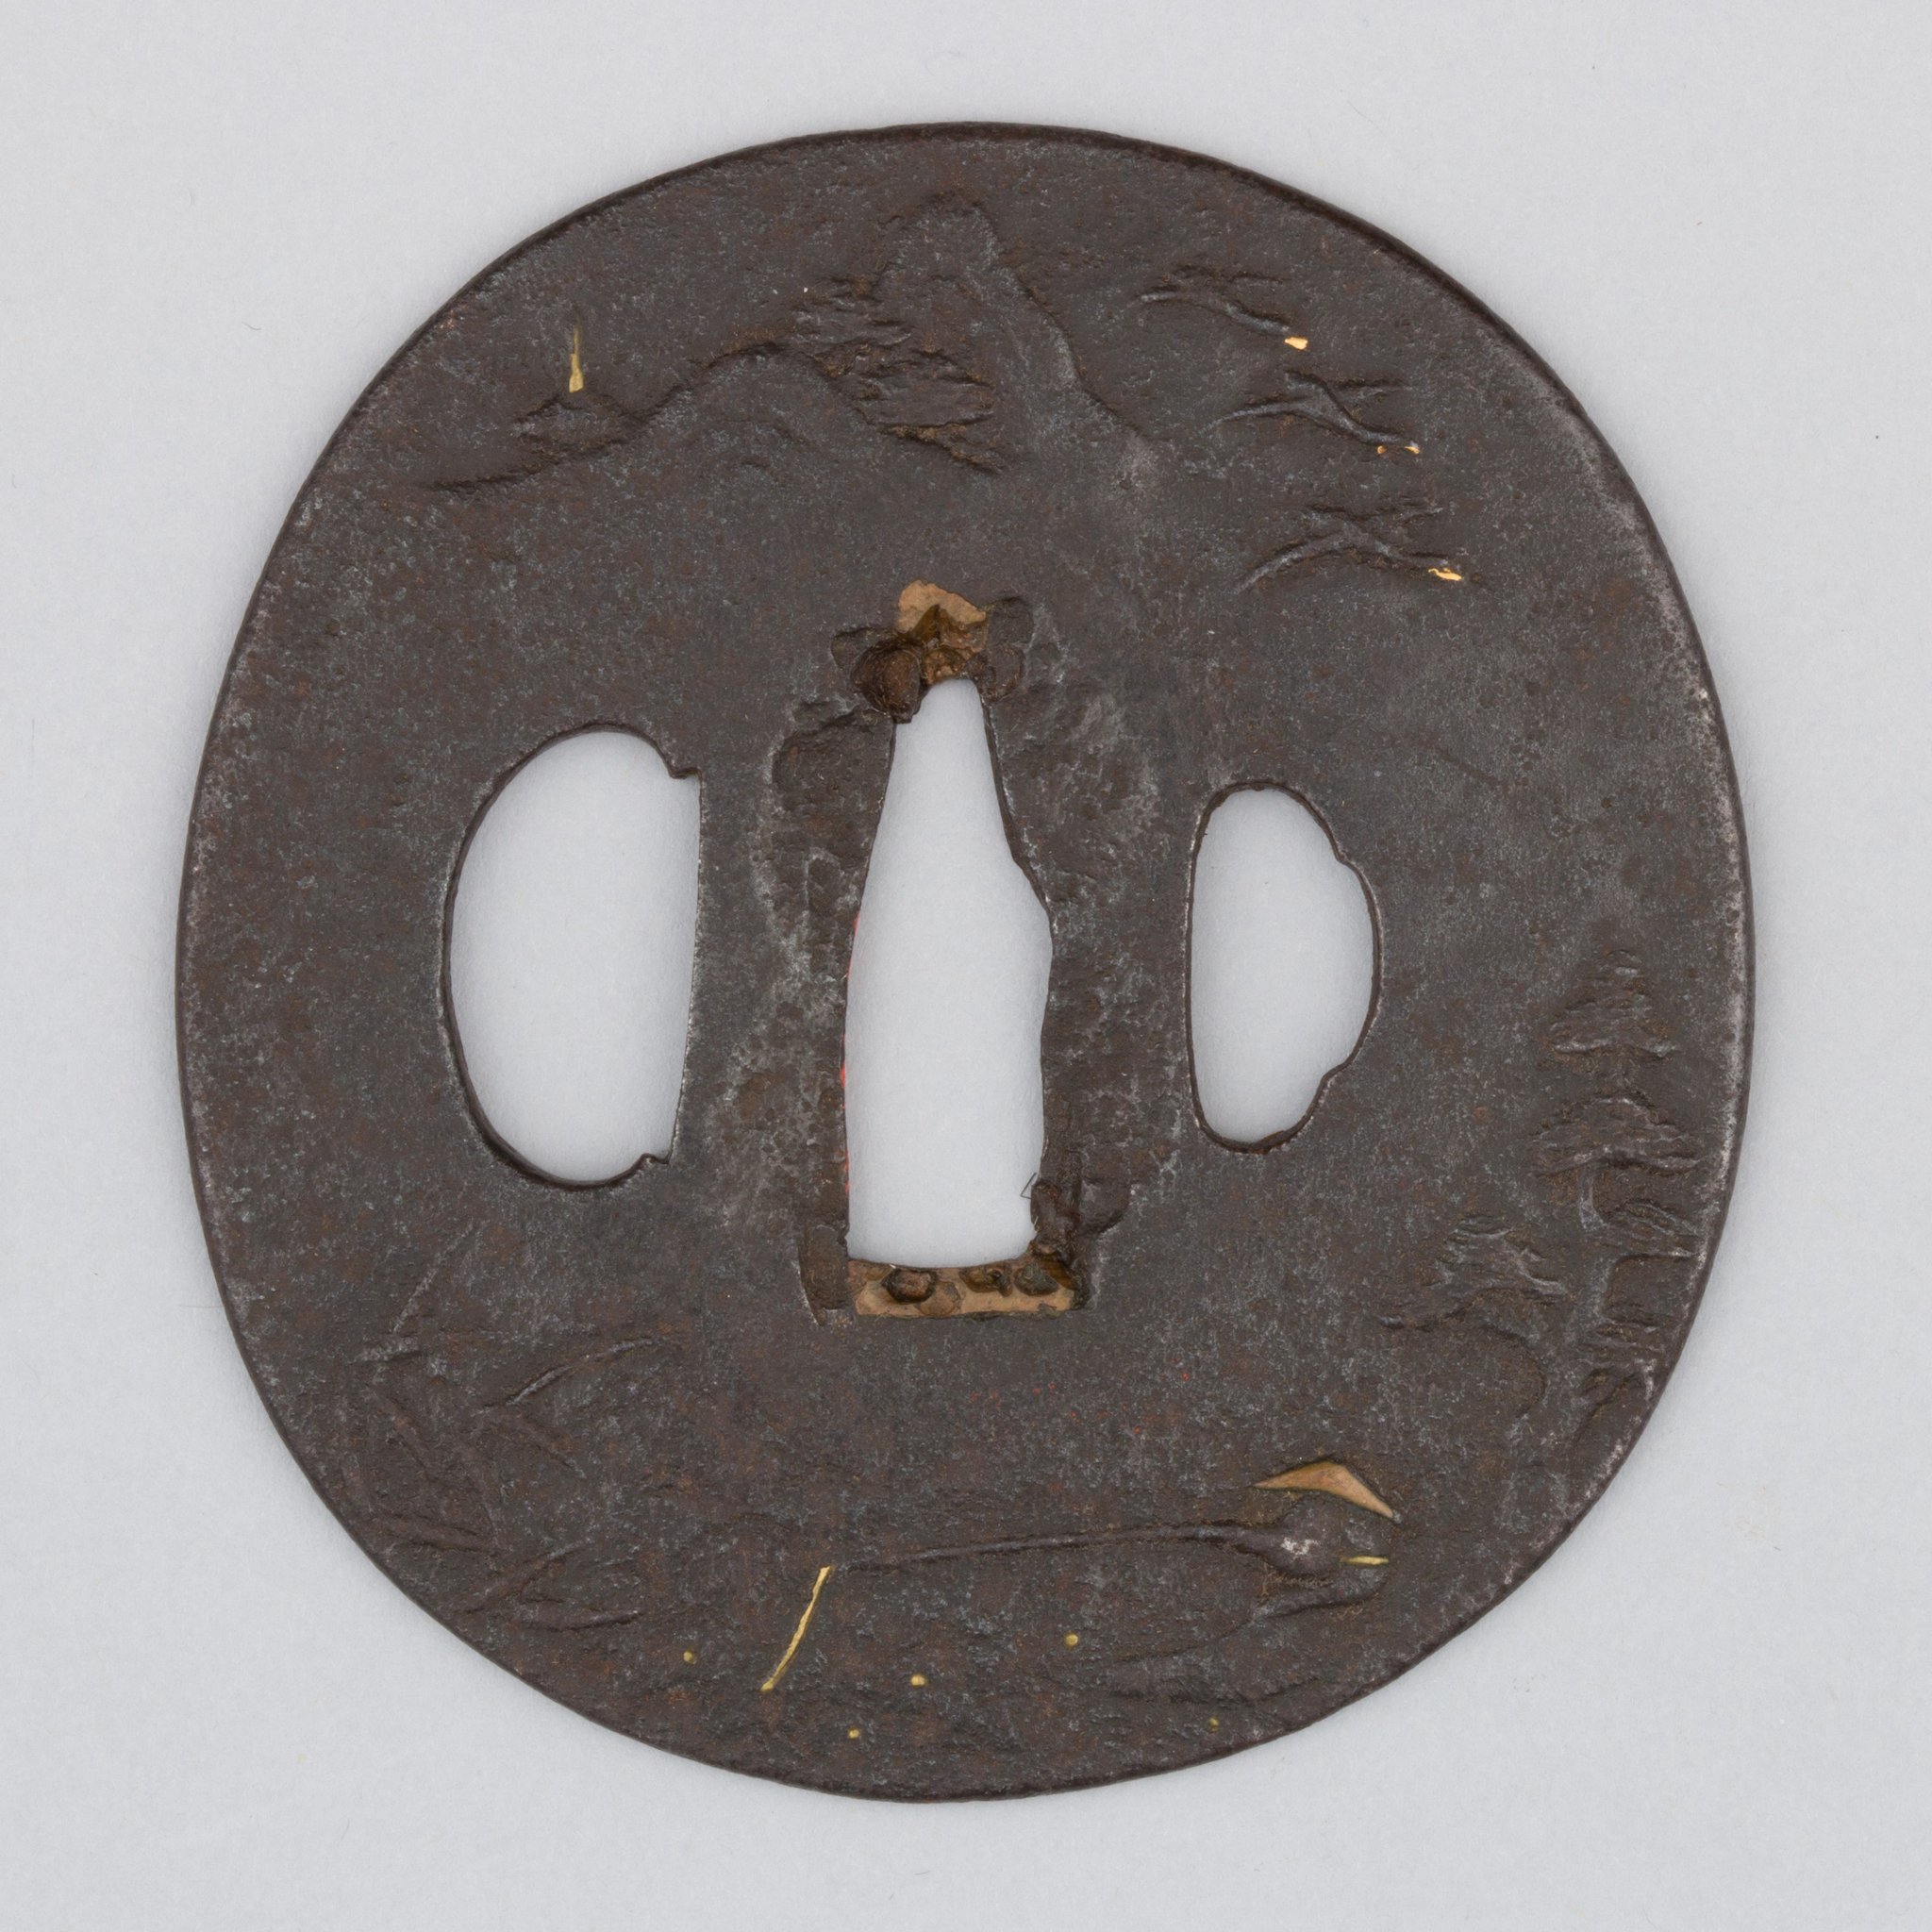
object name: sword guard tsuba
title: Sword Guard (Tsuba)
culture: japanese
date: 1701-1800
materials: copper, iron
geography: japan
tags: human figures,geese